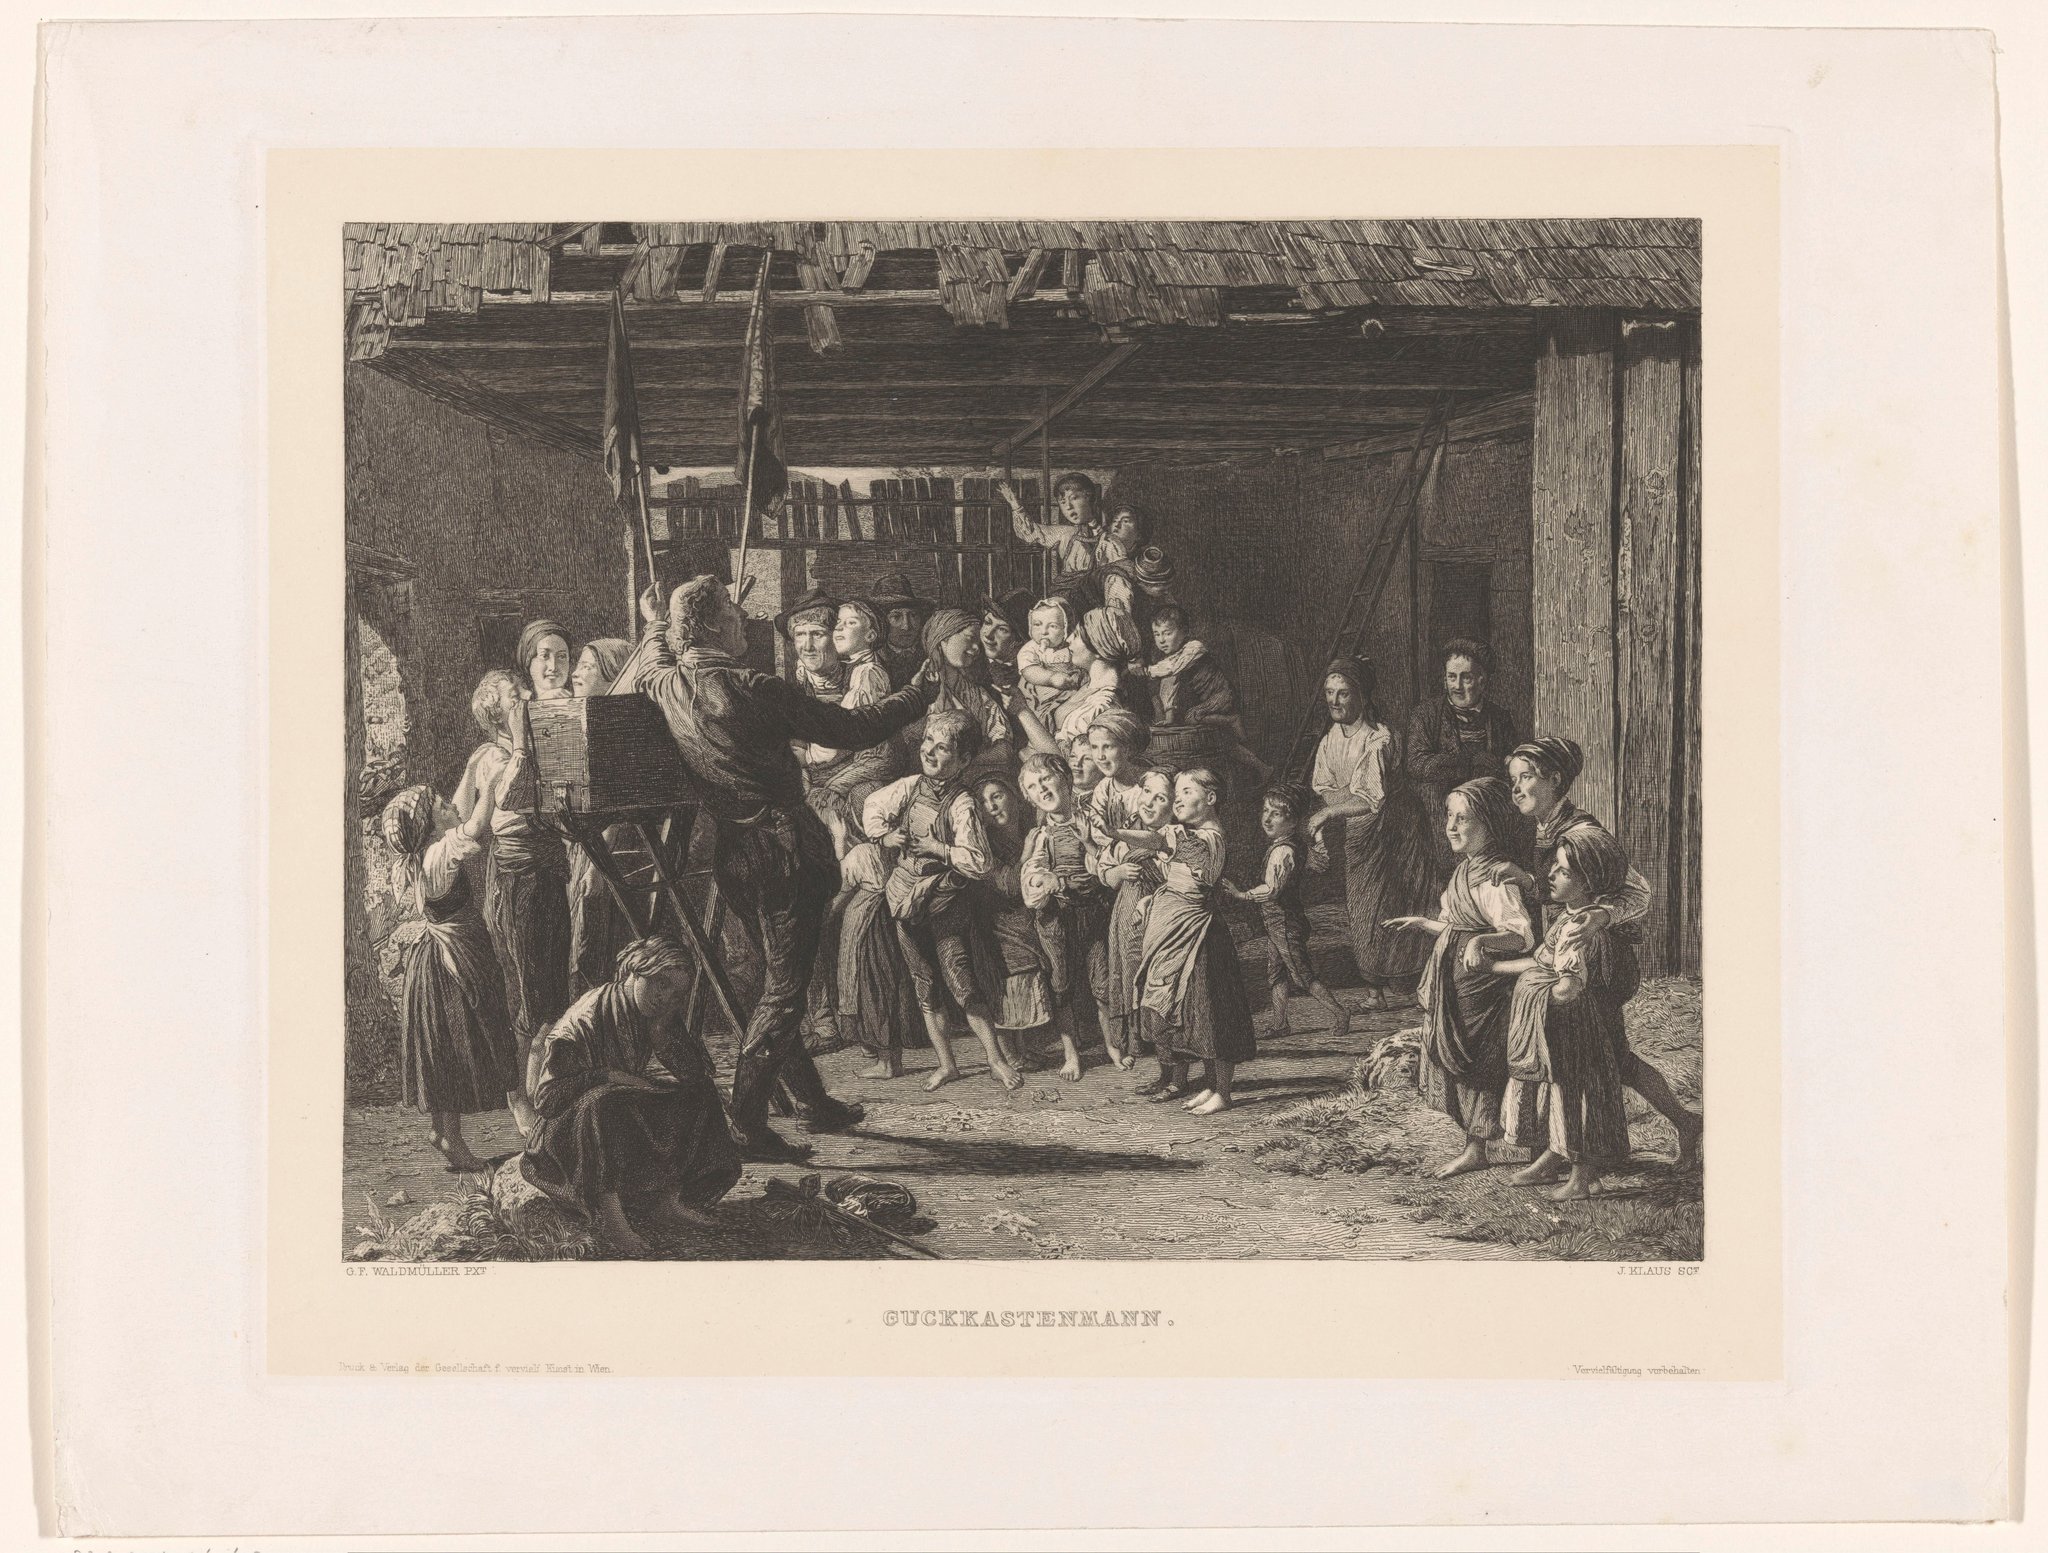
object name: print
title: Guckkastenmann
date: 1857-1893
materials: paper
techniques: drypoint, engraving, etching, roulette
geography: vienna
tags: performance in the open air (pleasure fair), shed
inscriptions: collector's mark: Lugt 4779, collector's mark: Lugt 2228, collector's mark: Lugt 4780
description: In een boerenschuur staat een man naast een kijkkast waarop twee vlaggen zijn bevestigd. Om hem heen vrolijke kinderen en volwassenen. Op de voorgrond zit een somber kijkend meisje op een steen, naast haar een knapzak.